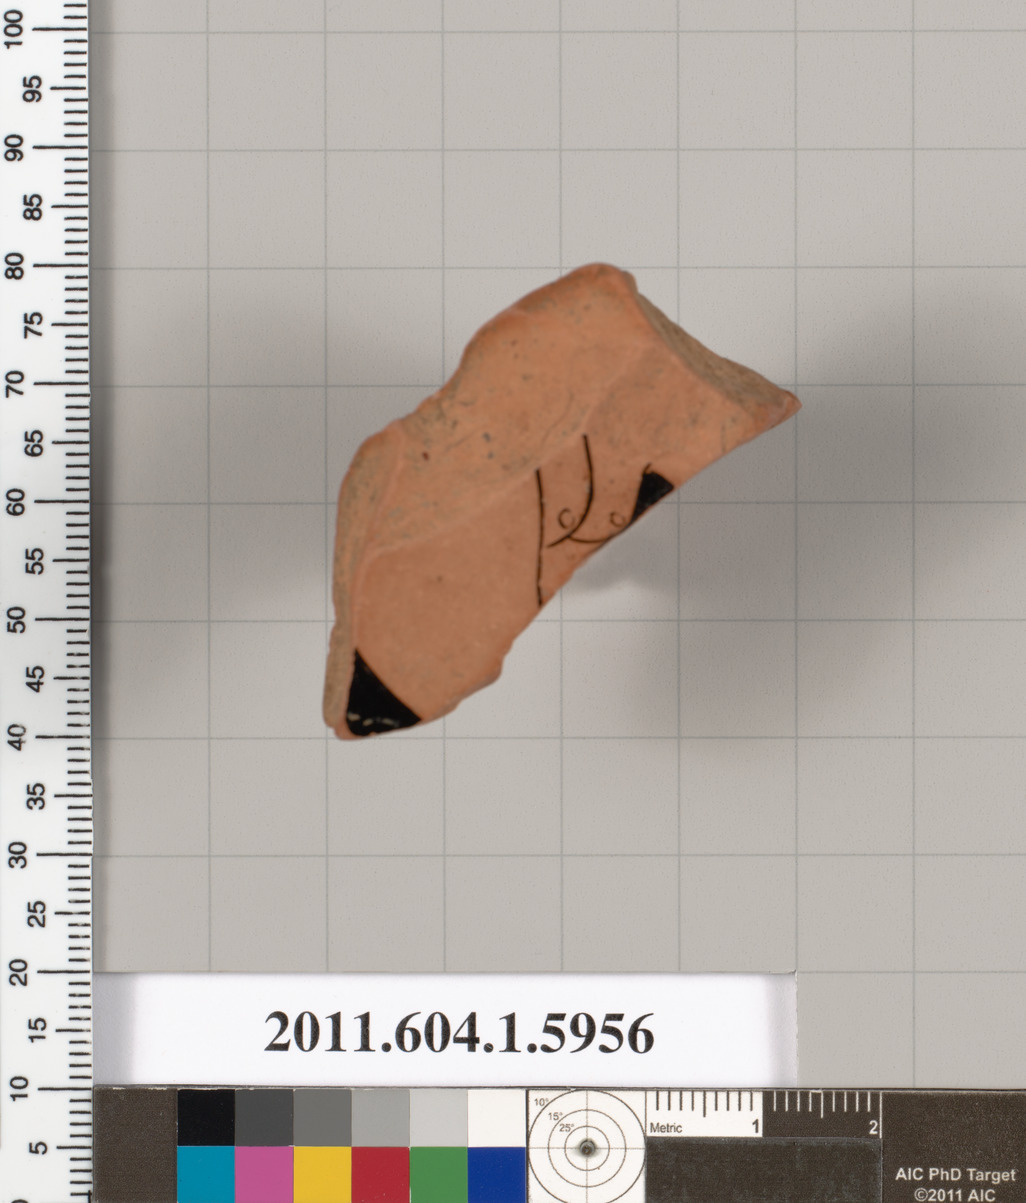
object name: kylix fragment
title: Terracotta fragment of a kylix (drinking cup)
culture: greek, attic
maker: skythes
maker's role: artist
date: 433-567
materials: terracotta